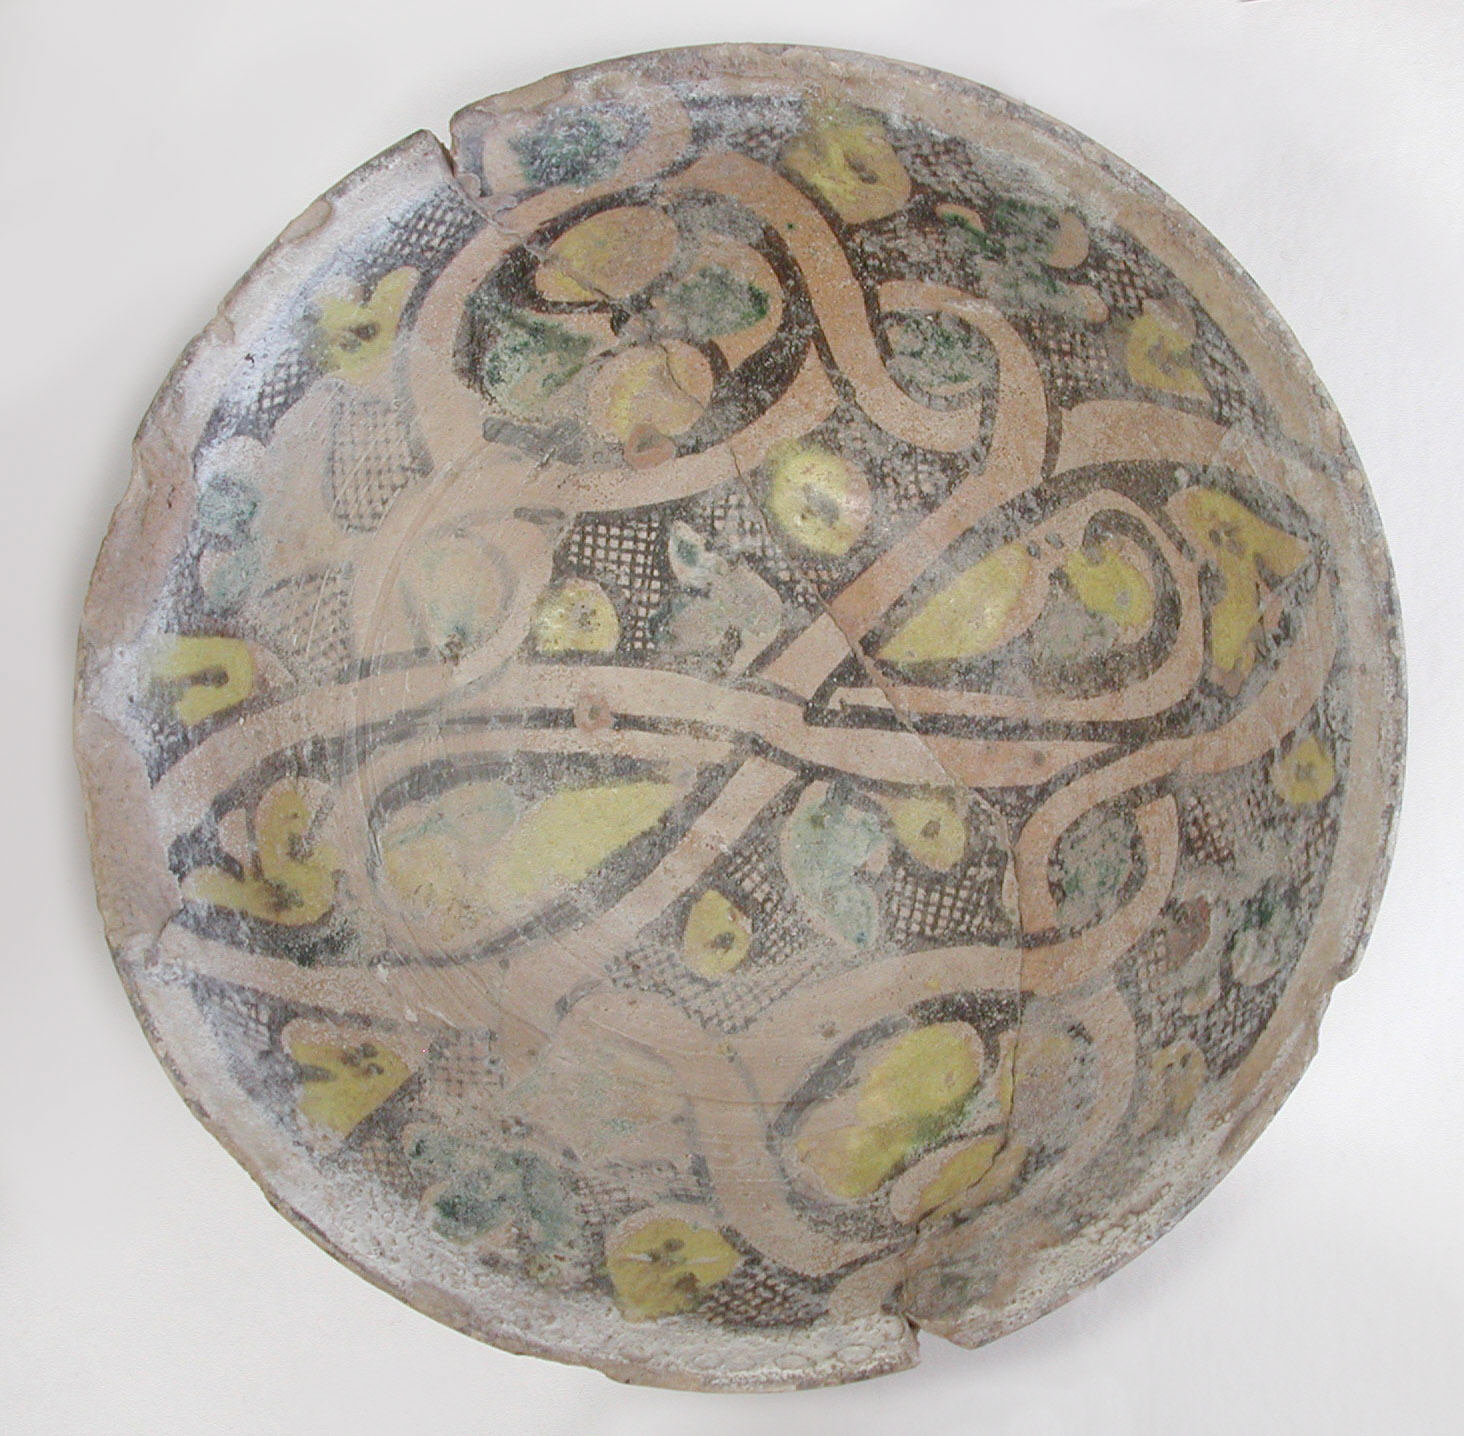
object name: bowl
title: Buffware Bowl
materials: earthenware, glaze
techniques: polychrome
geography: iran